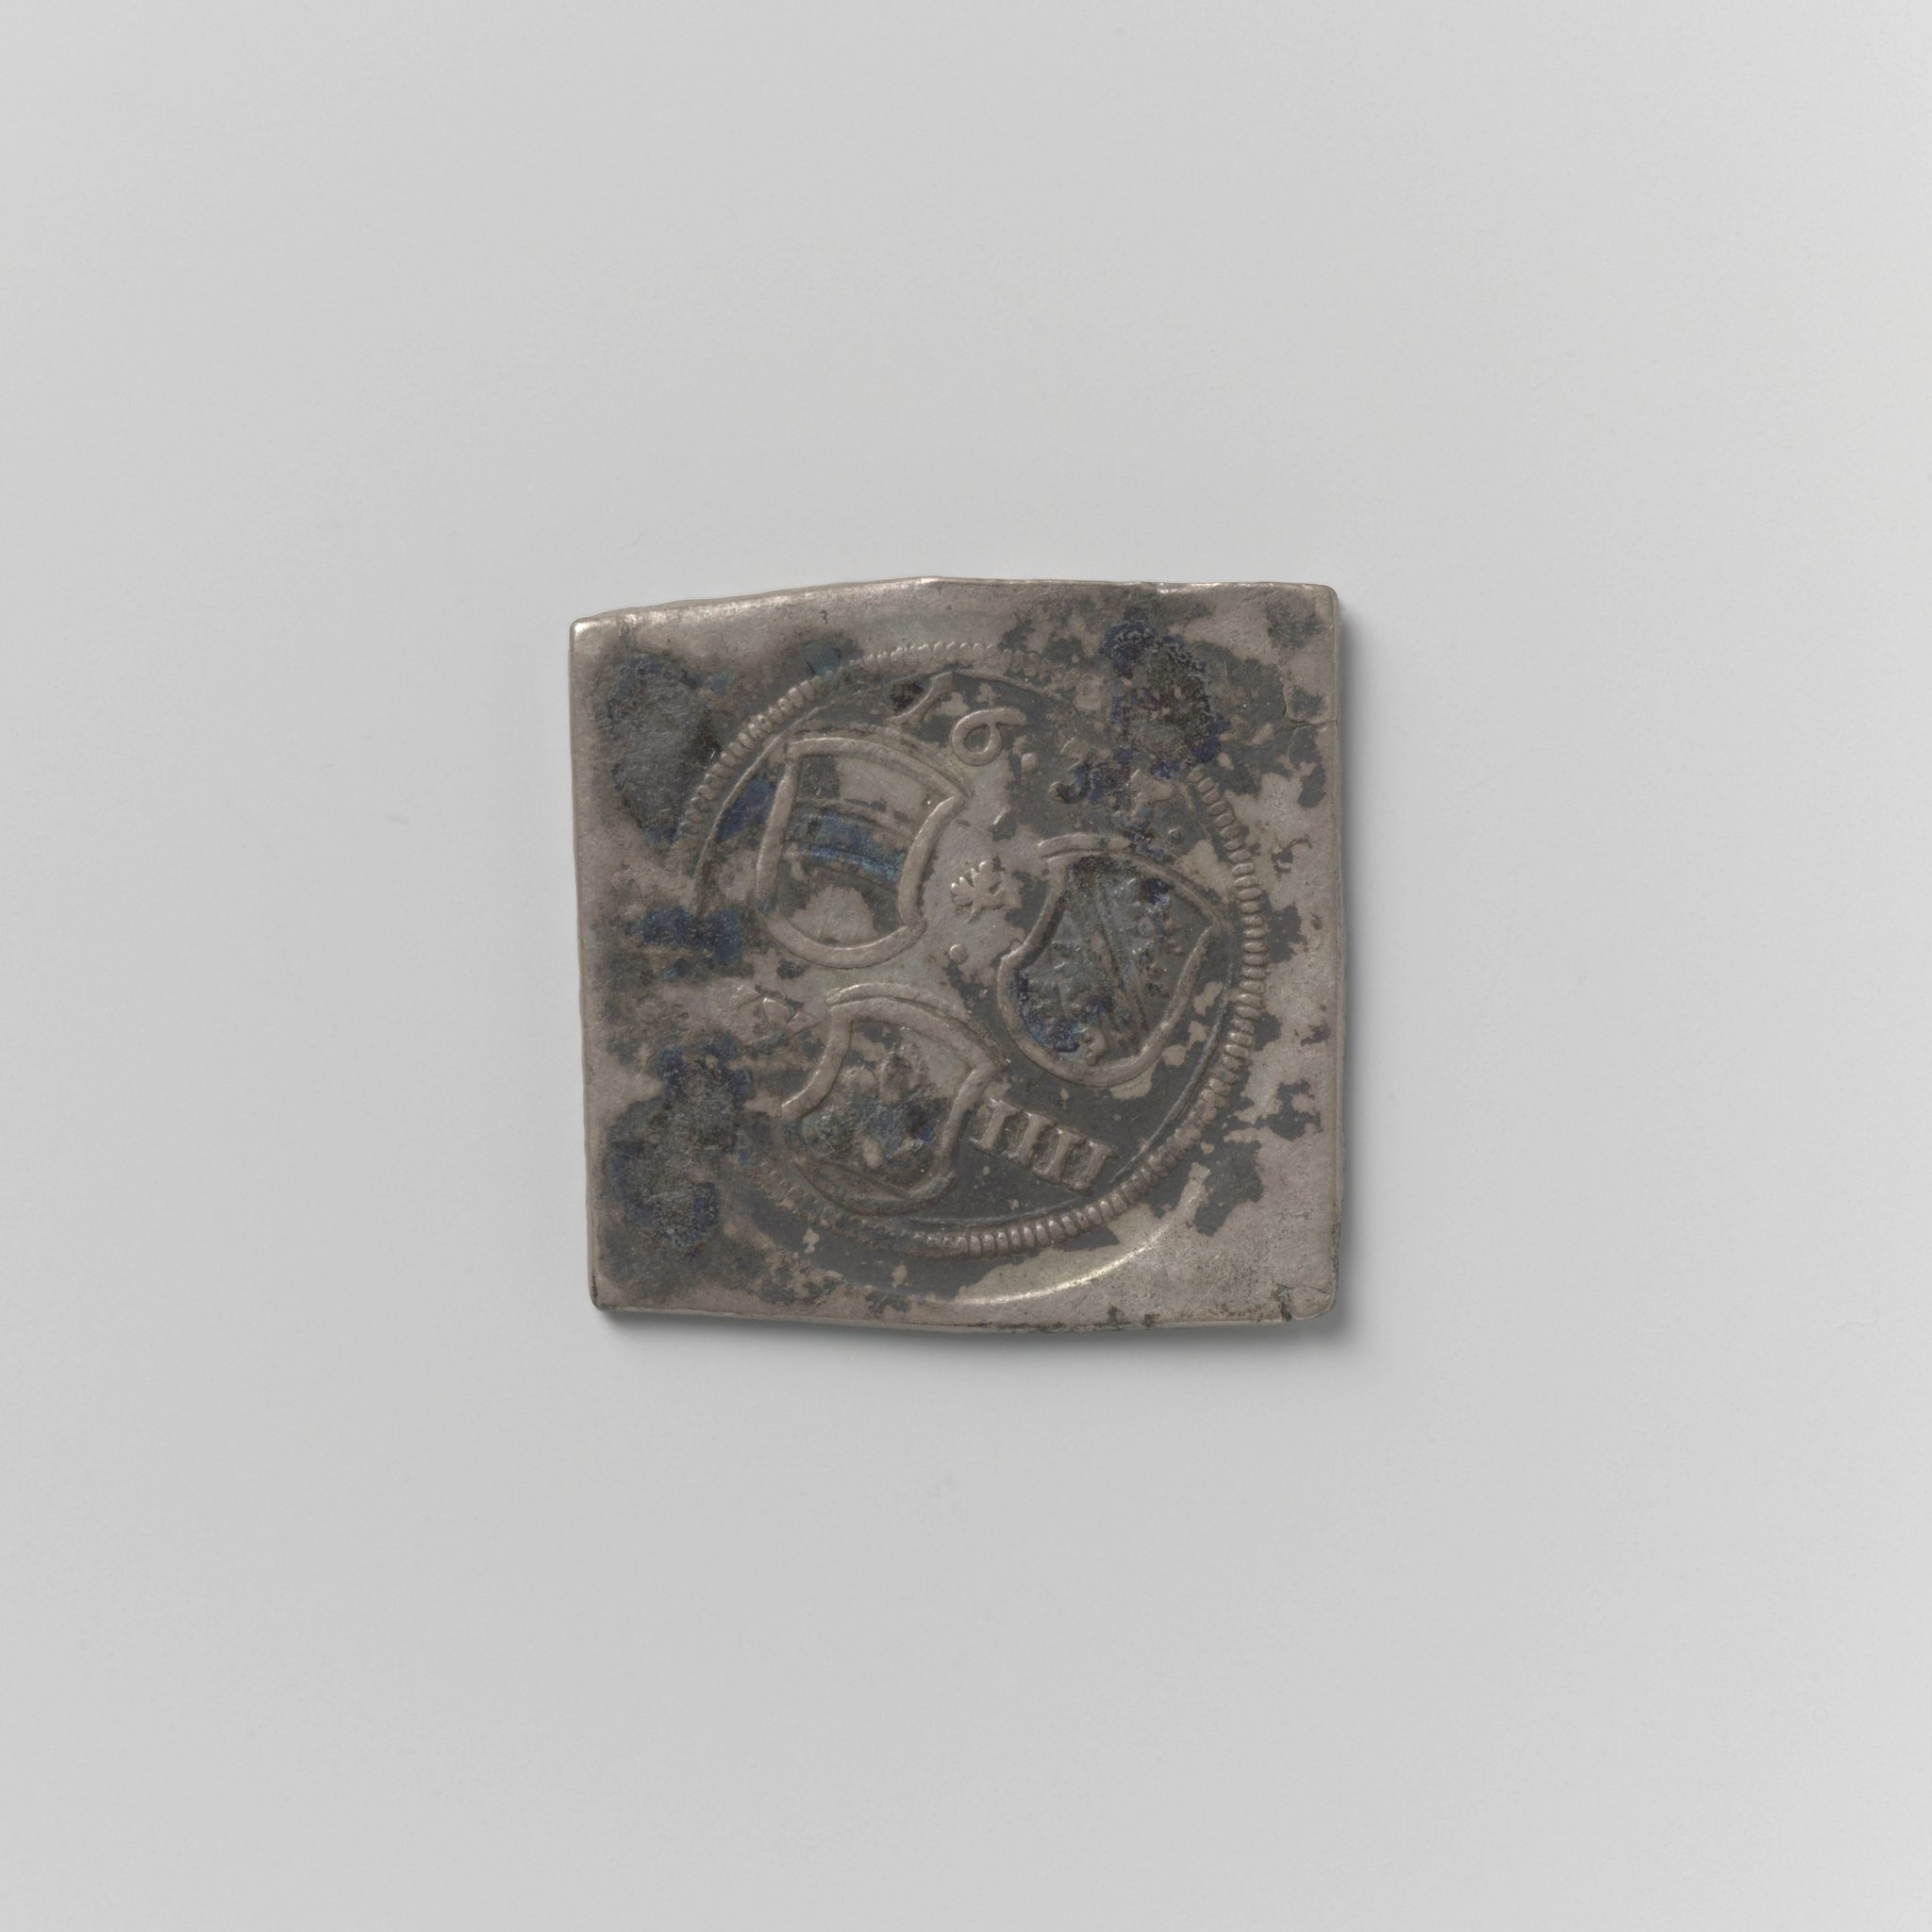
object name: vierentwintig batz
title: vierentwintig batz, noodmunt uit Breisach, geslagen tijdens het beleg door de Zweden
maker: Anonymous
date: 1633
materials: silver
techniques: striking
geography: breisach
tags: breisach, beleg van breisach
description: Ruitvormige zilveren noodmunt. Voorzijde: in ronde stempel: jaartal boven twee wapenschilden, gescheiden door klaverblaadje boven punt; daaronder: wapenschild tussen Romeinse cijfer XXIIII. Keerzijde: in ronde stempel: opschrift.